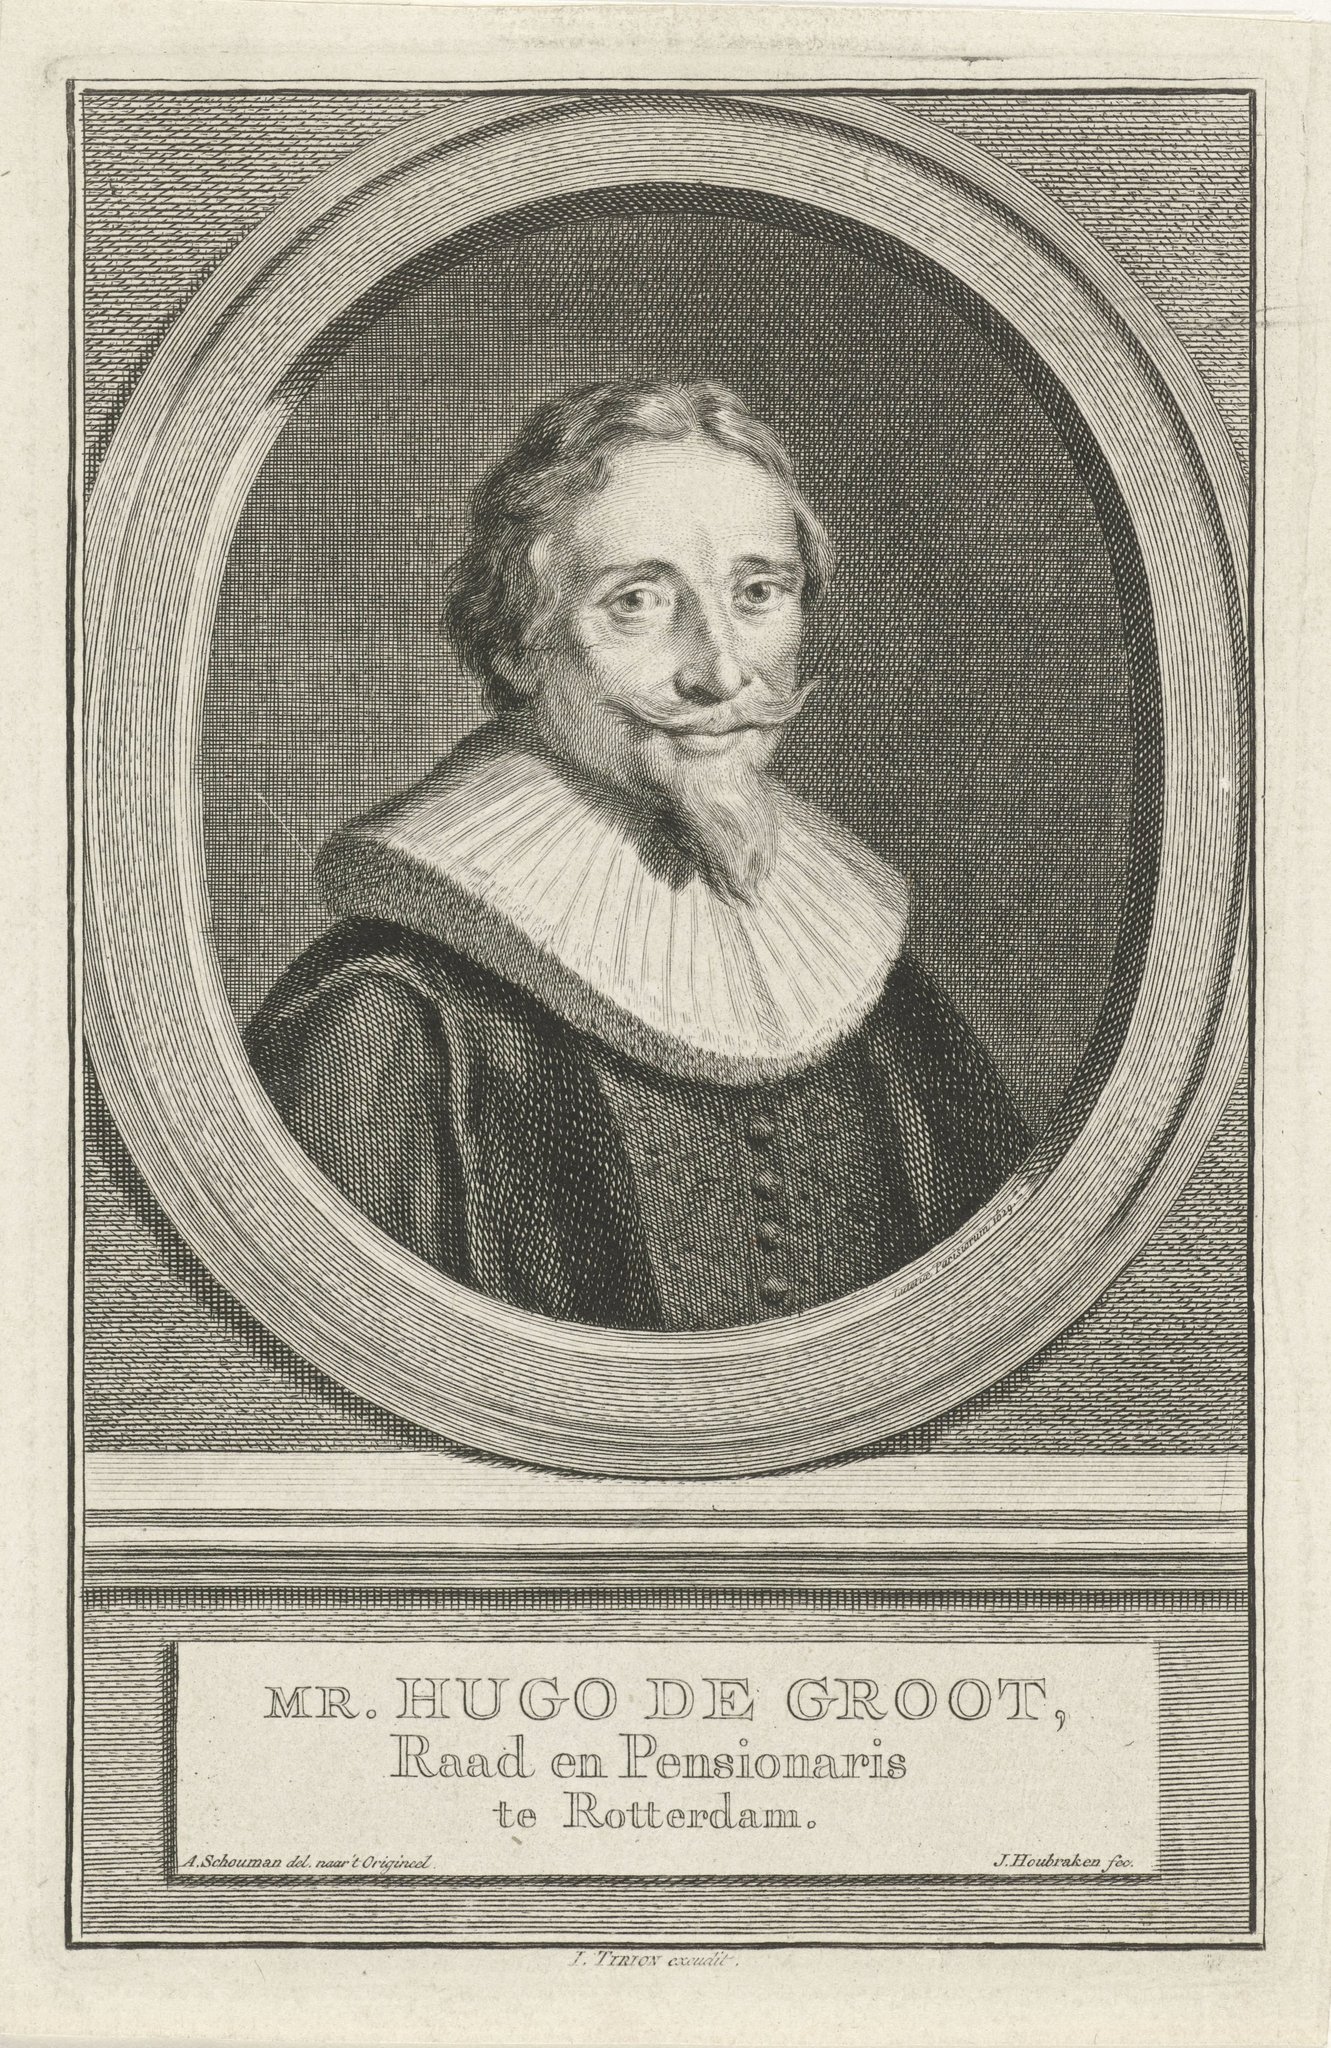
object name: print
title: Portret van Hugo de Groot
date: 1749-1759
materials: paper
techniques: engraving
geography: amsterdam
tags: delft, hugo de groot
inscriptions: collector's mark: Lugt 2228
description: Prent ook gebruikt in: Jan Wagenaar, Vaderlandsche historie, vervattende de geschiedenissen der nu Vereenigde Nederlanden, inzonderheid die van Holland (...), 21 delen. Amsterdam, Isaak Tirion, 1749-59.